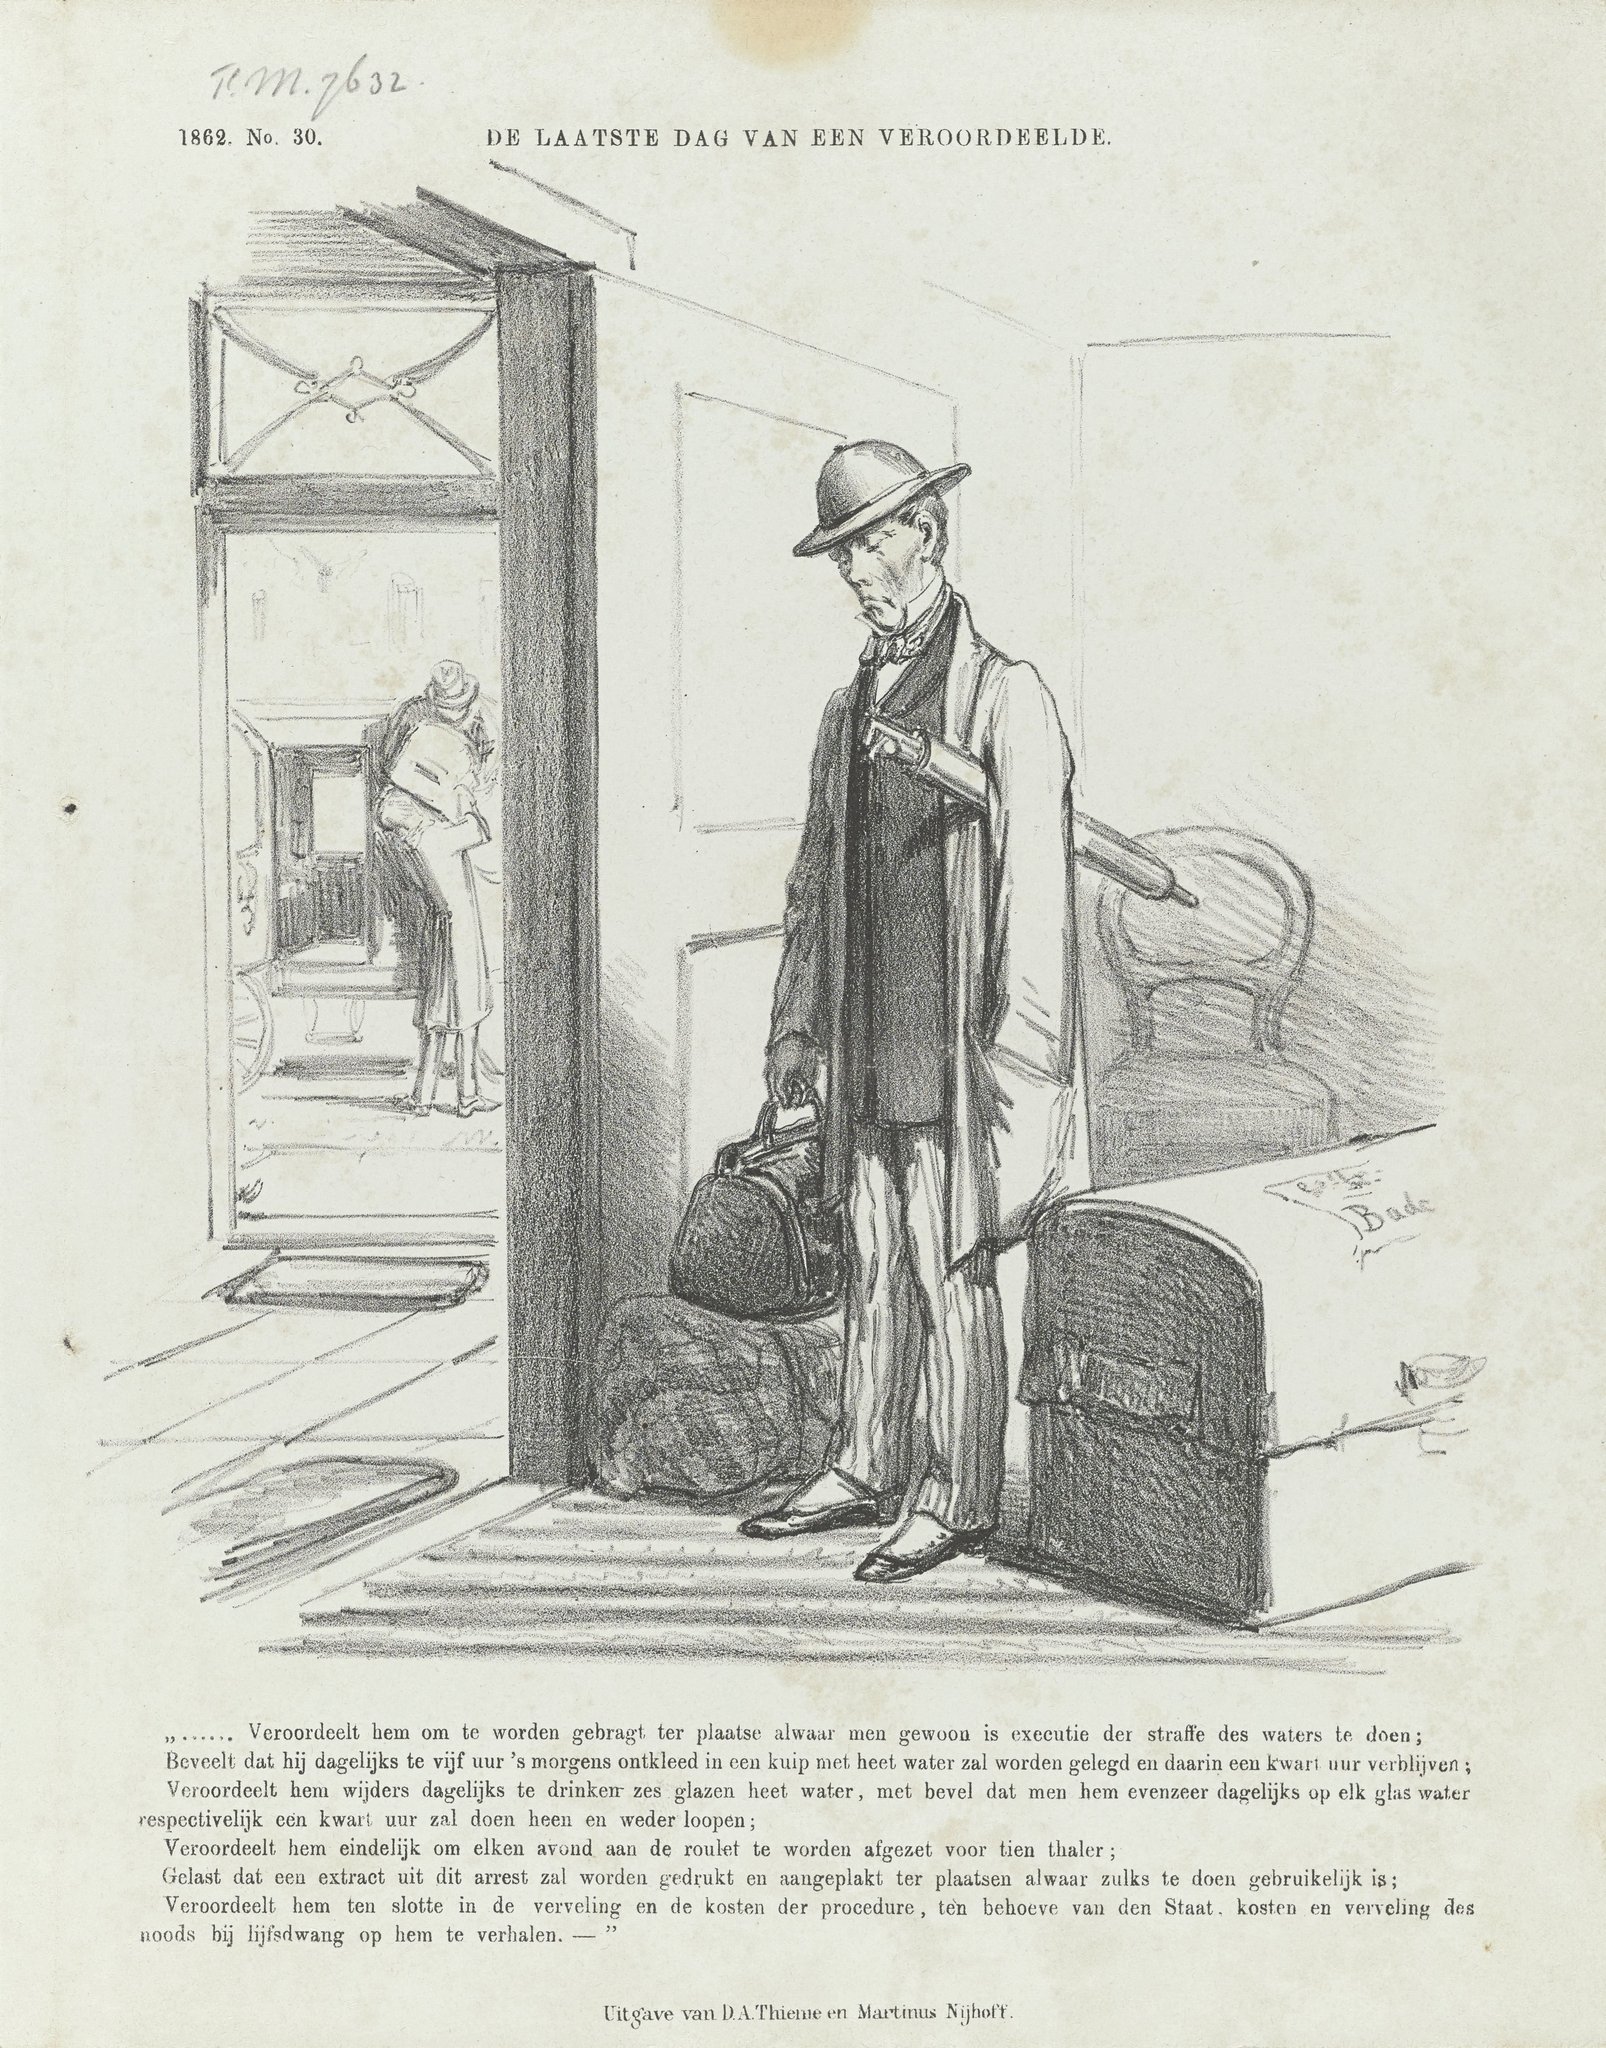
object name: cartoon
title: De laatste dag van een veroordeelde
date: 1862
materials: paper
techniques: lithograph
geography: arnhem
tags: the hague, johan rudolf thorbecke, watering-place, spa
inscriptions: collector's mark: Lugt 2228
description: Spotprent waarin een verdrietig kijkende man (Thorbecke?) ingepakt staat voor een reis naar een kuuroord om te baden. Plaat verschenen bij het weekblad De Nederlandsche Spectator, nr. 30, 26 juli 1862.